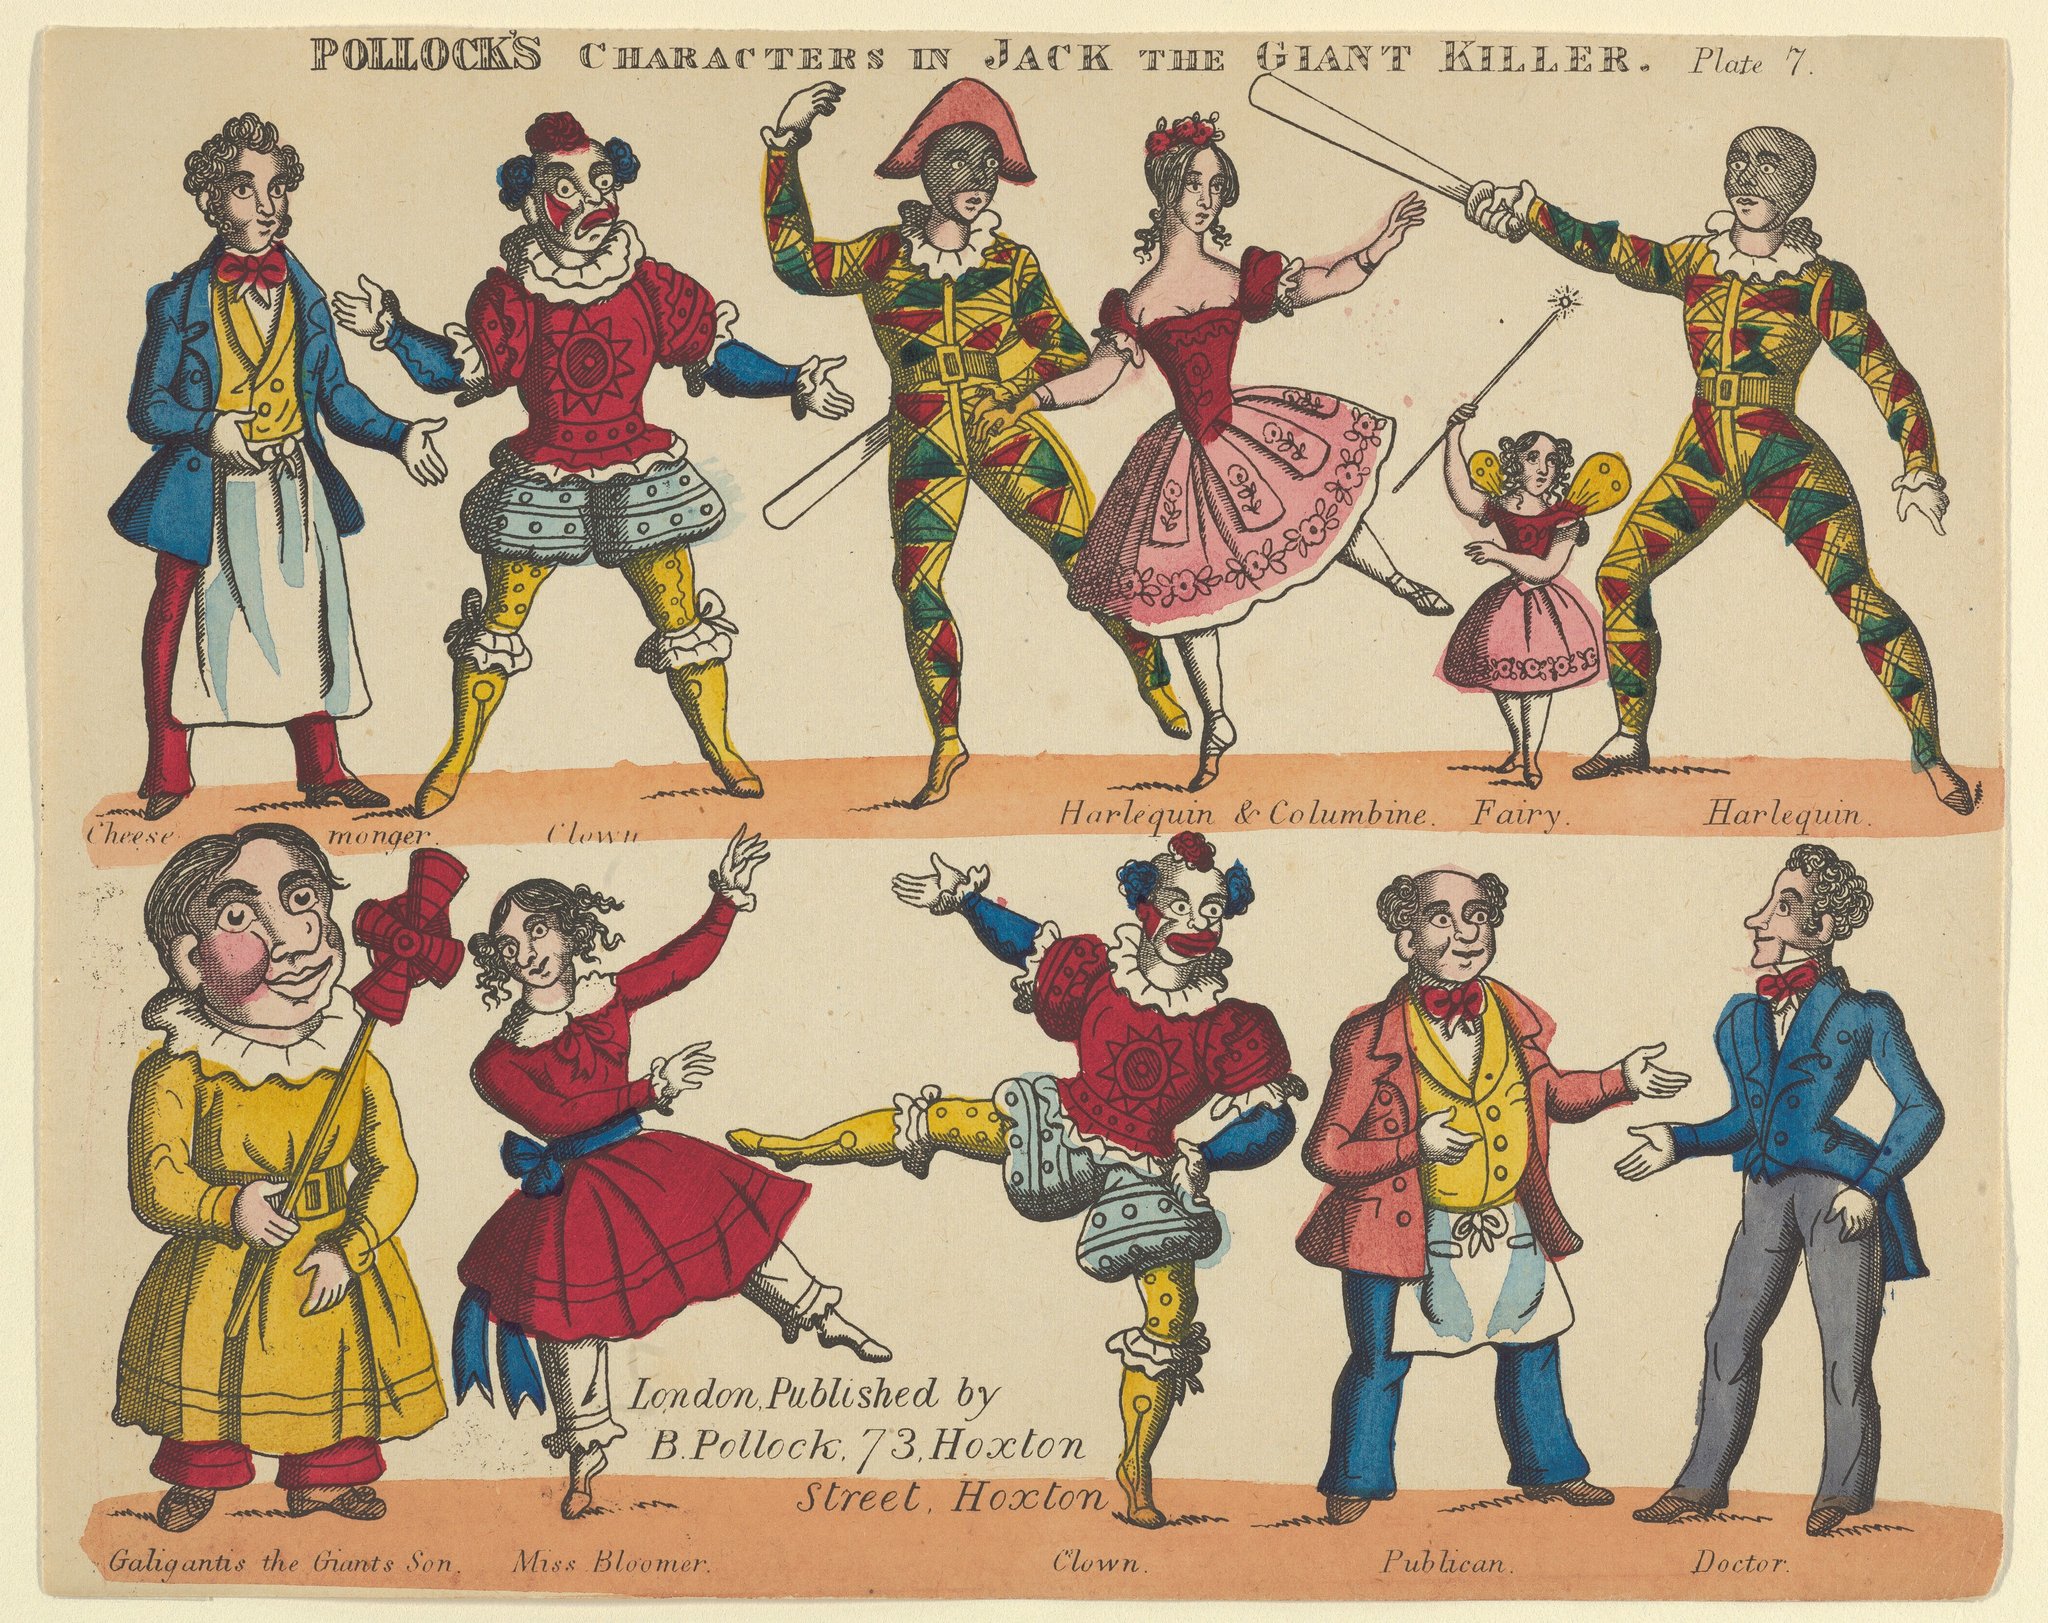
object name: print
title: Characters, from Jack and the Giant Killer, Plate 7 for a Toy Theater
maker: benjamin pollock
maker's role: publisher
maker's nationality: british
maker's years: 1857-1937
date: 1870-1890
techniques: lithograph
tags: men,women,clowns